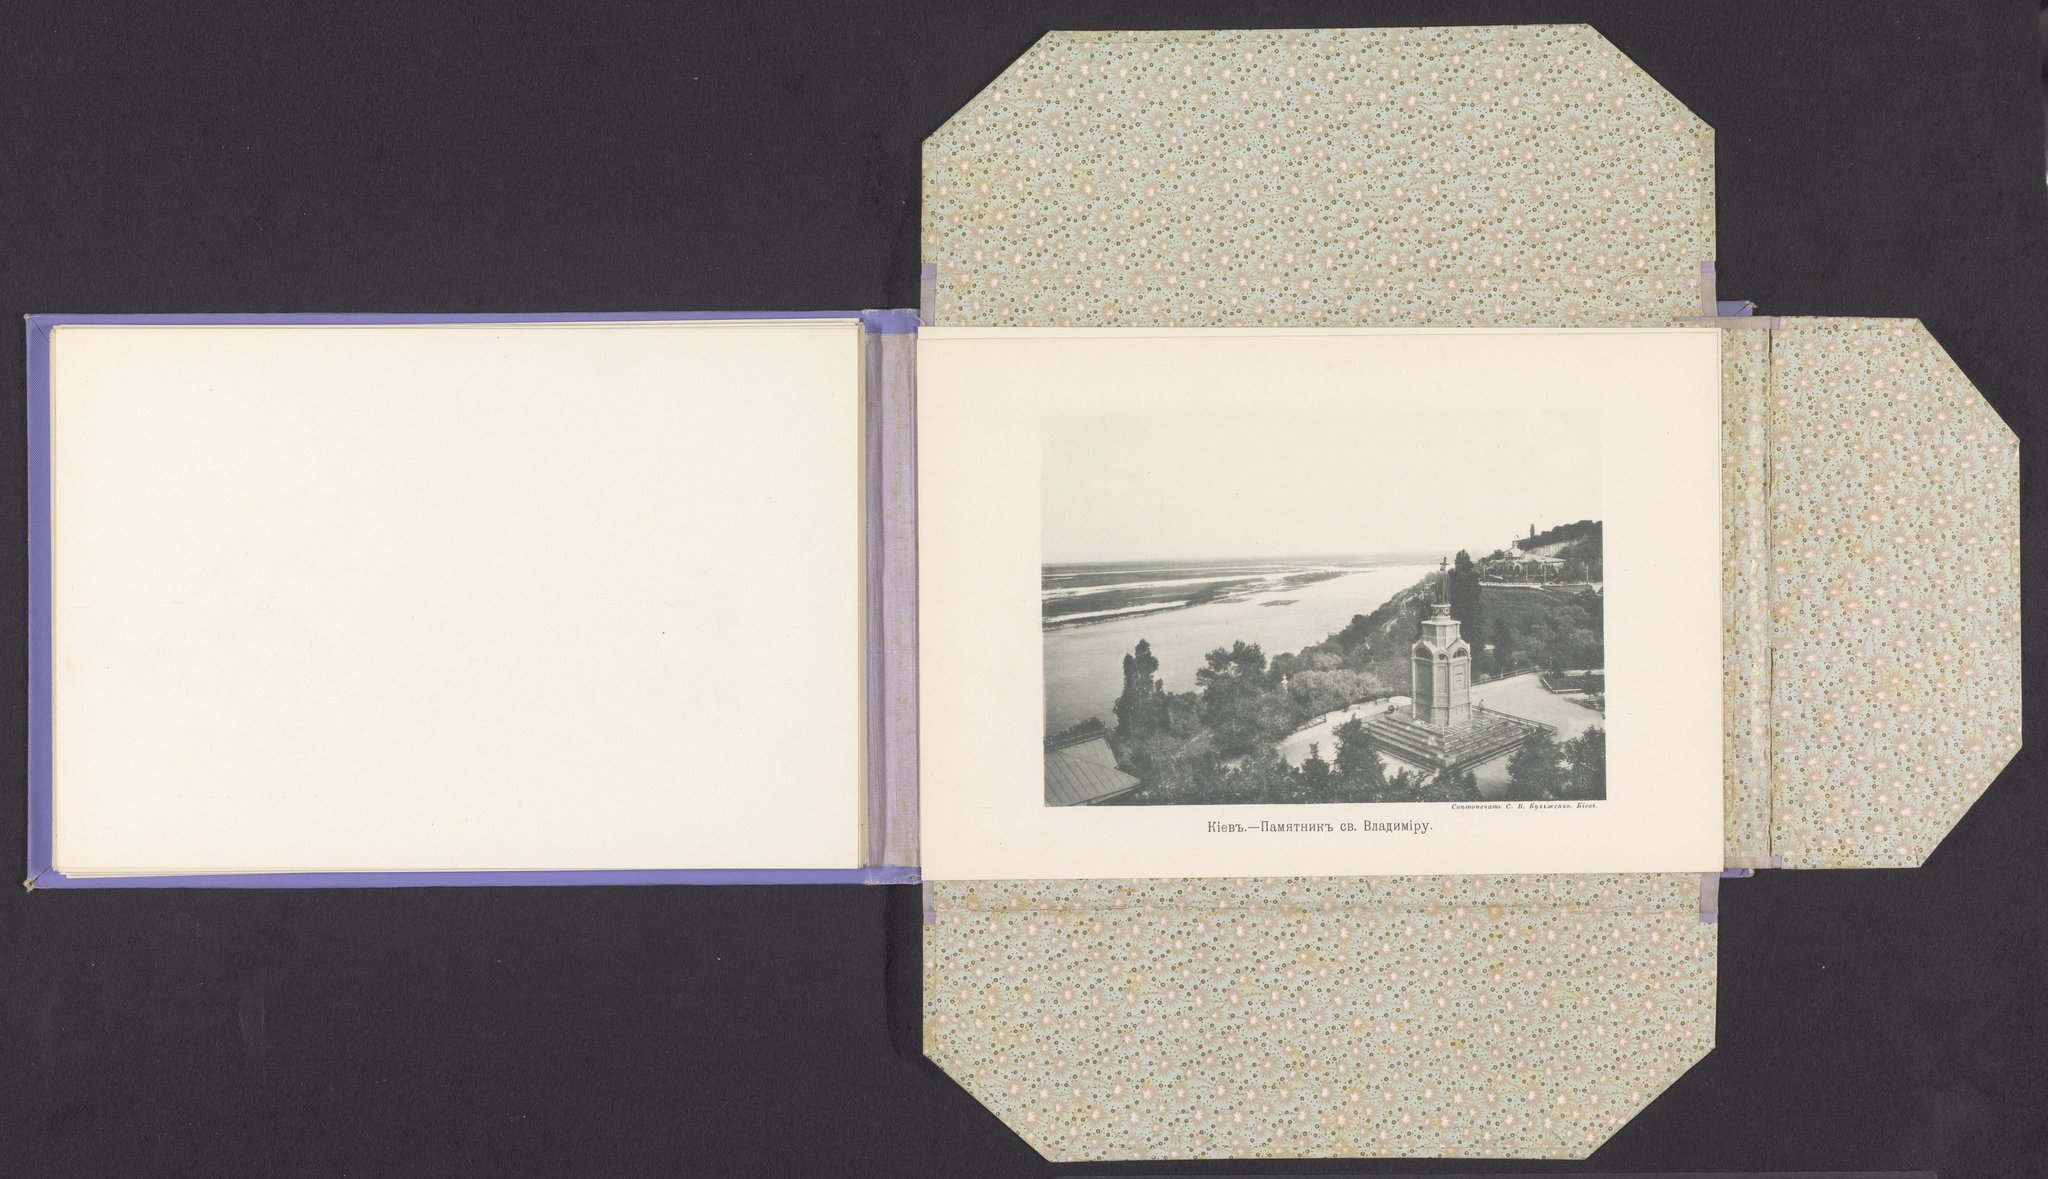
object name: page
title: Kieвъ.- Пaмятникъ Св. Влaдимiру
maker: Anonymous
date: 1886-1896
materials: paper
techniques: photograph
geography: kyiv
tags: monument, statue, sculpture